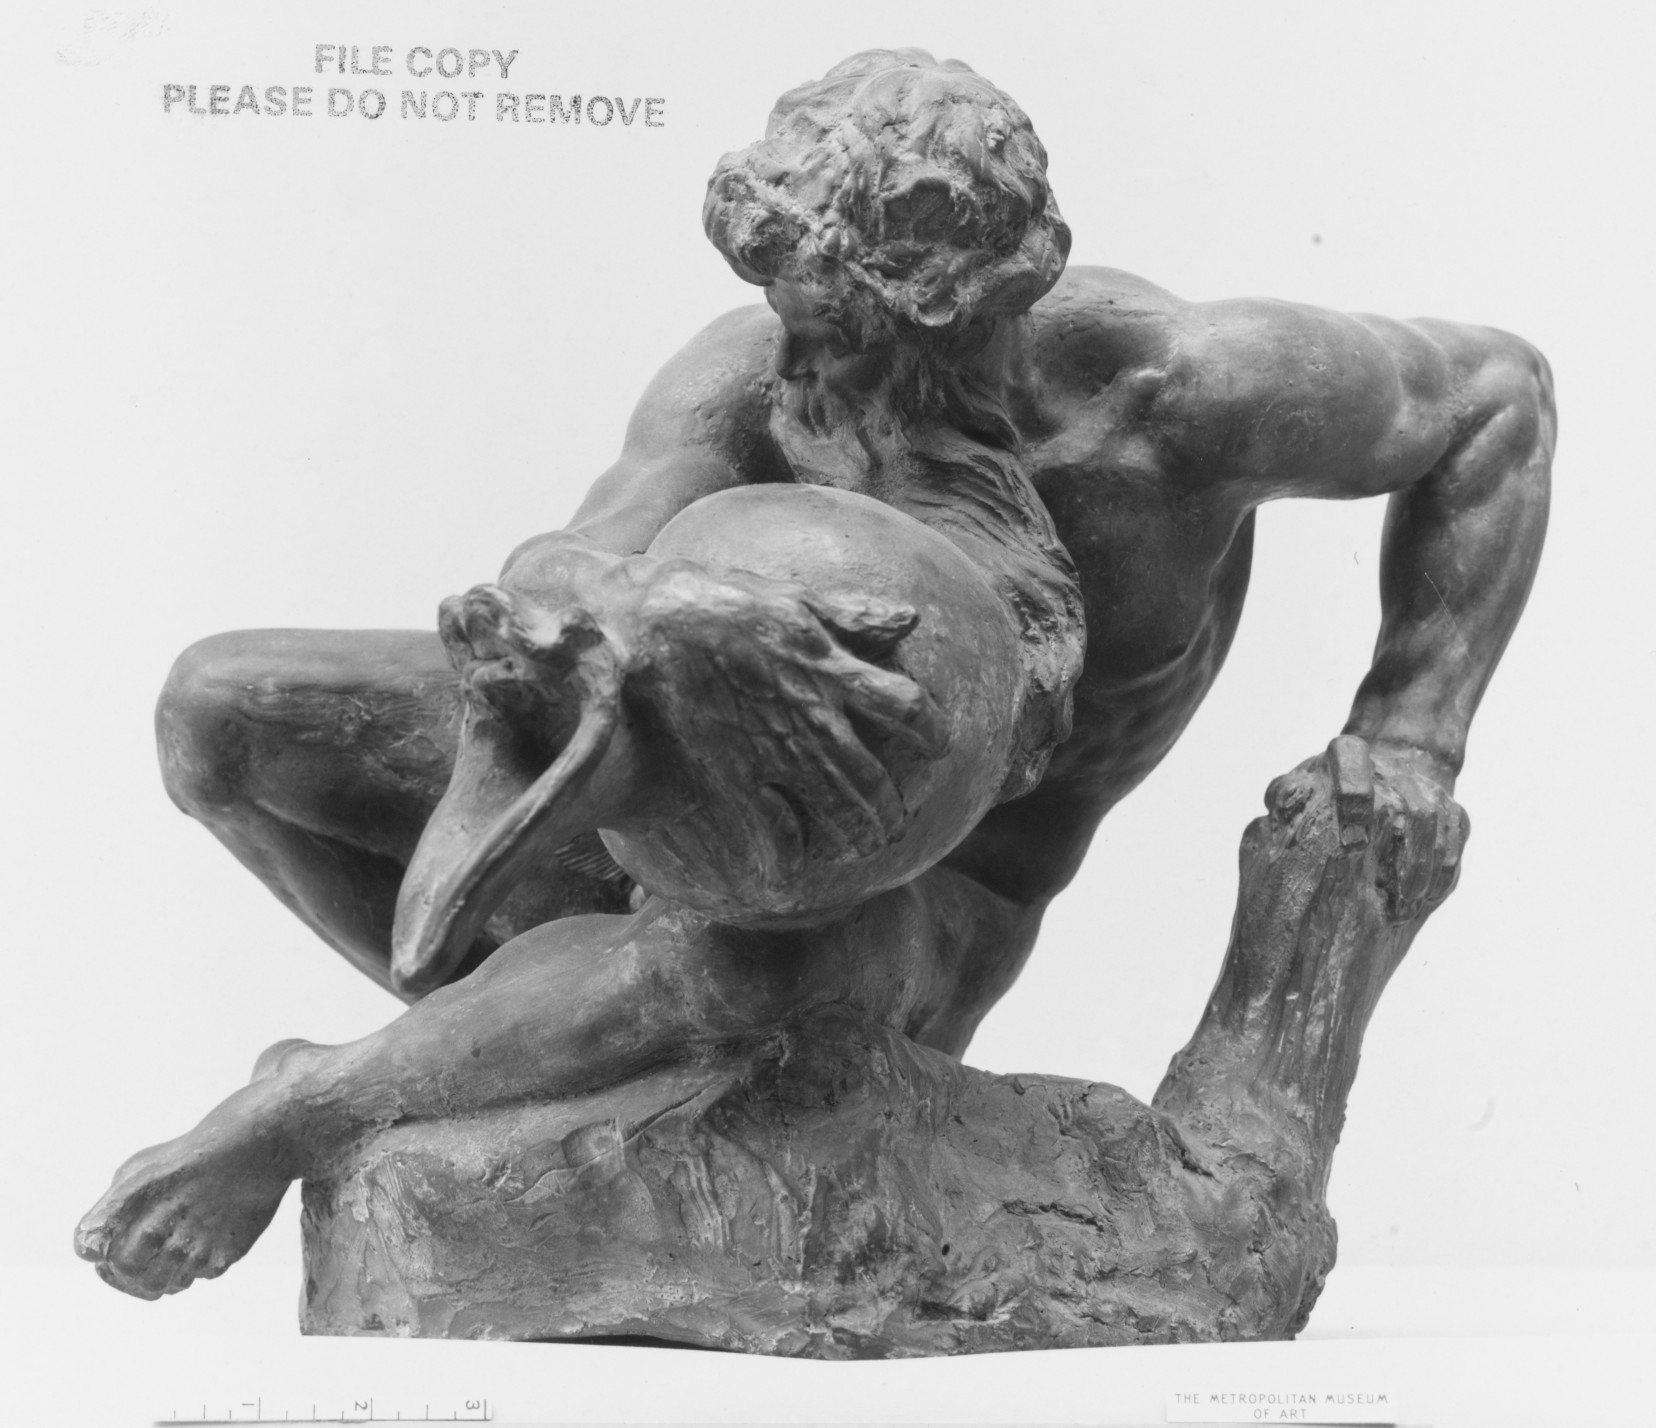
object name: statuette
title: River God (one of a pair)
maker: giambologna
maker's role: artist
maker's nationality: netherlandish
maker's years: 1529-1608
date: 1551-1600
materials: terracotta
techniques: casting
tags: male nudes